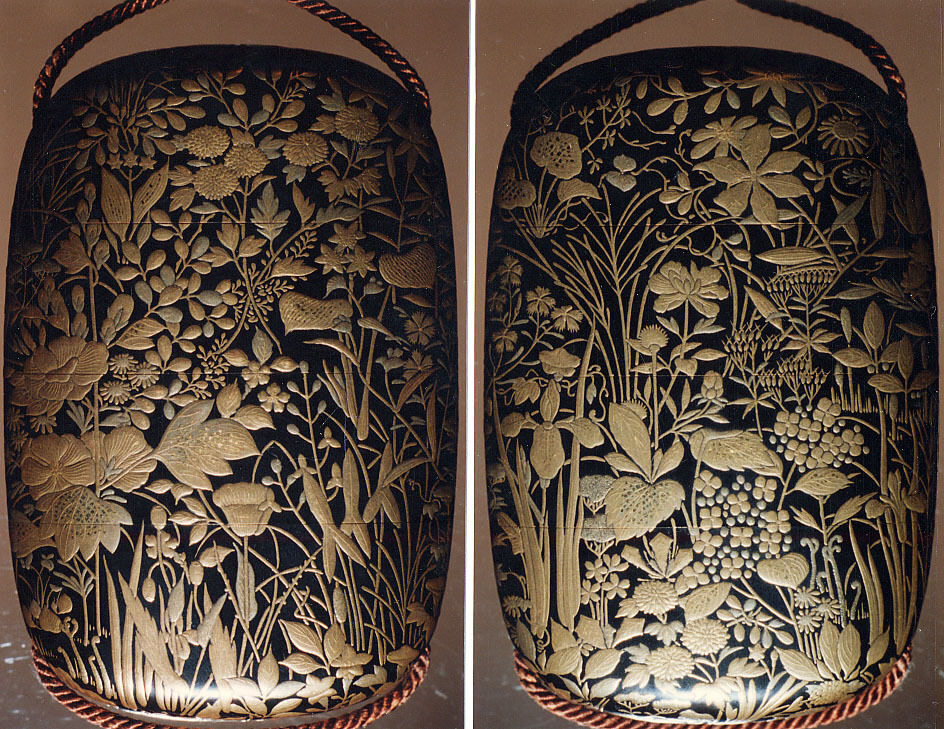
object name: inrō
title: Case (Inrō) with Design of Flowers and Grasses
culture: japanese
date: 1801-1900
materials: gold, lacquer, silver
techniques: fundame, hiramakie, roiro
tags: flowers